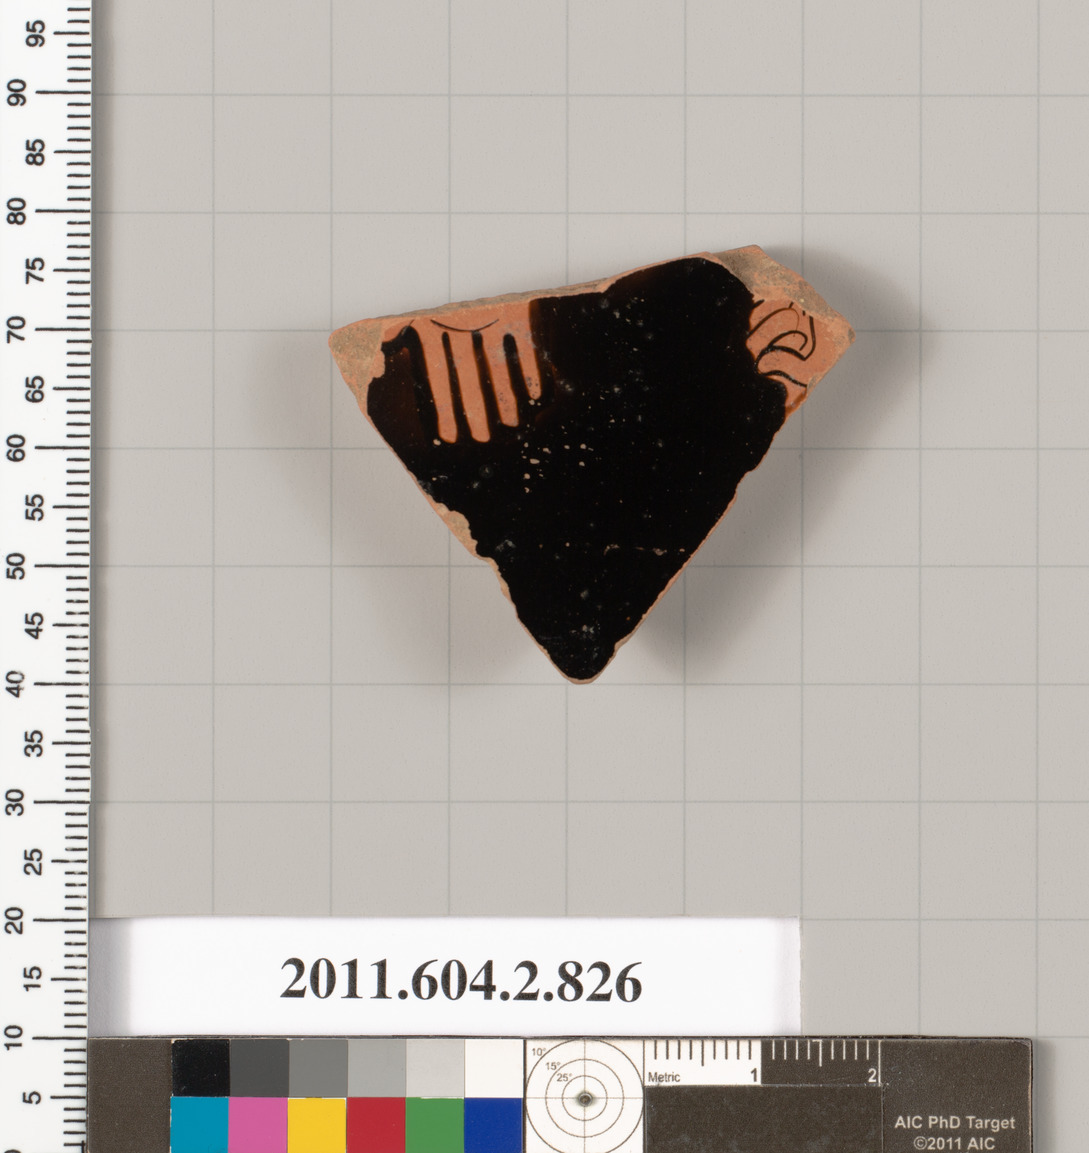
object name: bell krater fragment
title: Terracotta fragment of a bell-krater (bowl for mixing wine and water)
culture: greek, attic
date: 470-450 BCE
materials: terracotta